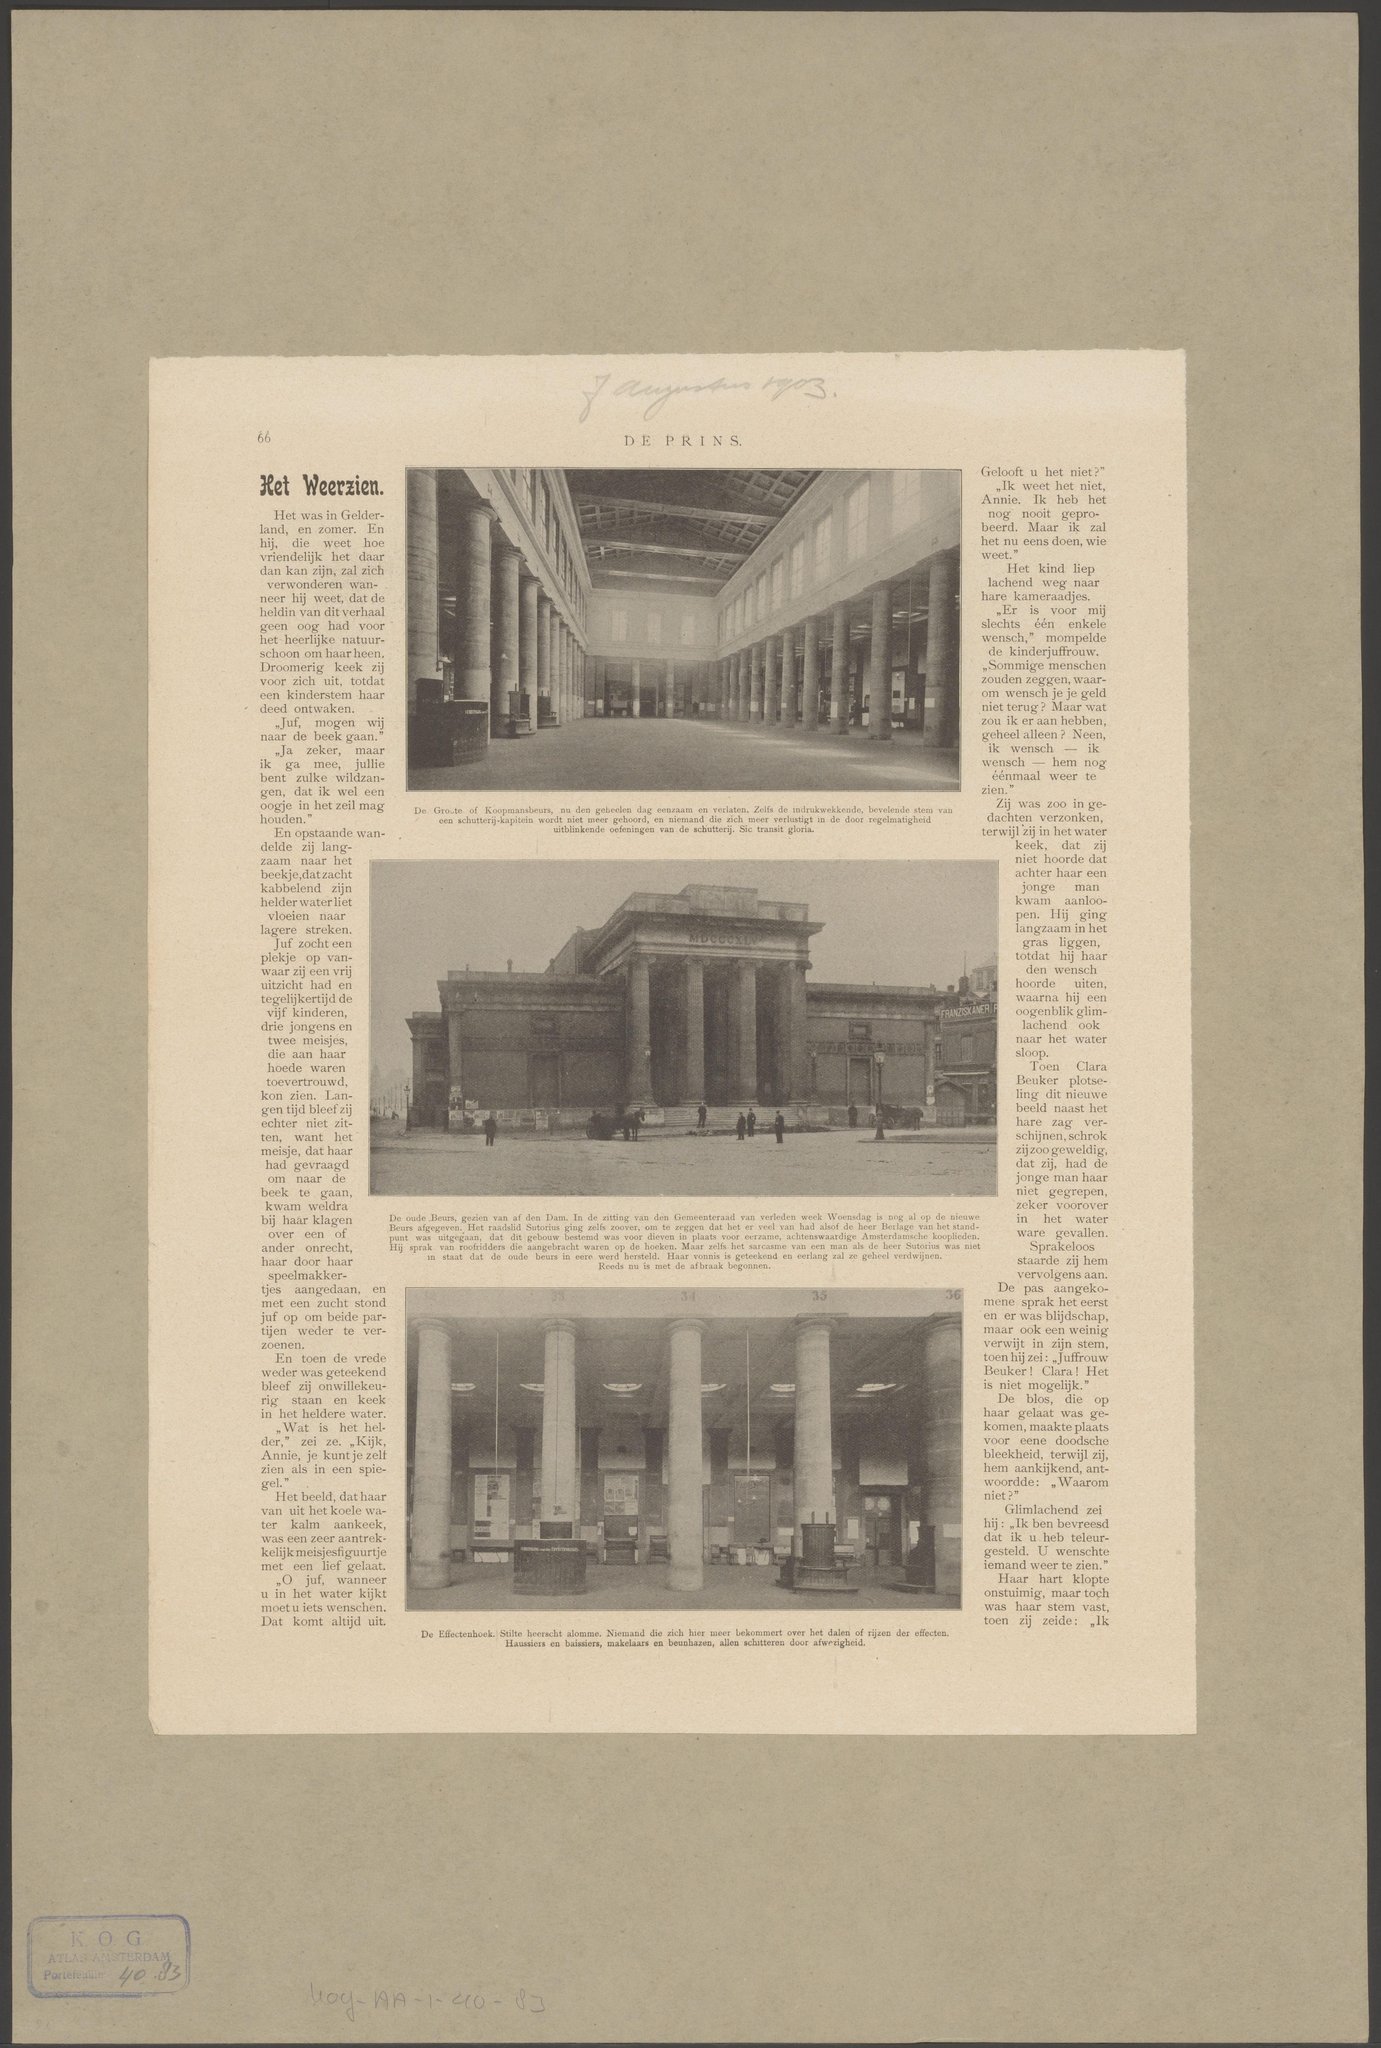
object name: photomechanical print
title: Interieur van en gezicht op de Beurs van Zocher te Amsterdam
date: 1903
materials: paper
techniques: letterpress printing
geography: netherlands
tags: stock exchange, stock-market, square, place, circus, etc. (+ city(-scape) with figures, staffage)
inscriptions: collector's mark: Lugt 1641b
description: Onderwerpsrubriek binnen de Atlas Amsterdam: Handel en Zeevaart: Hulpbeurs op de Dam en Beurs (Dam).